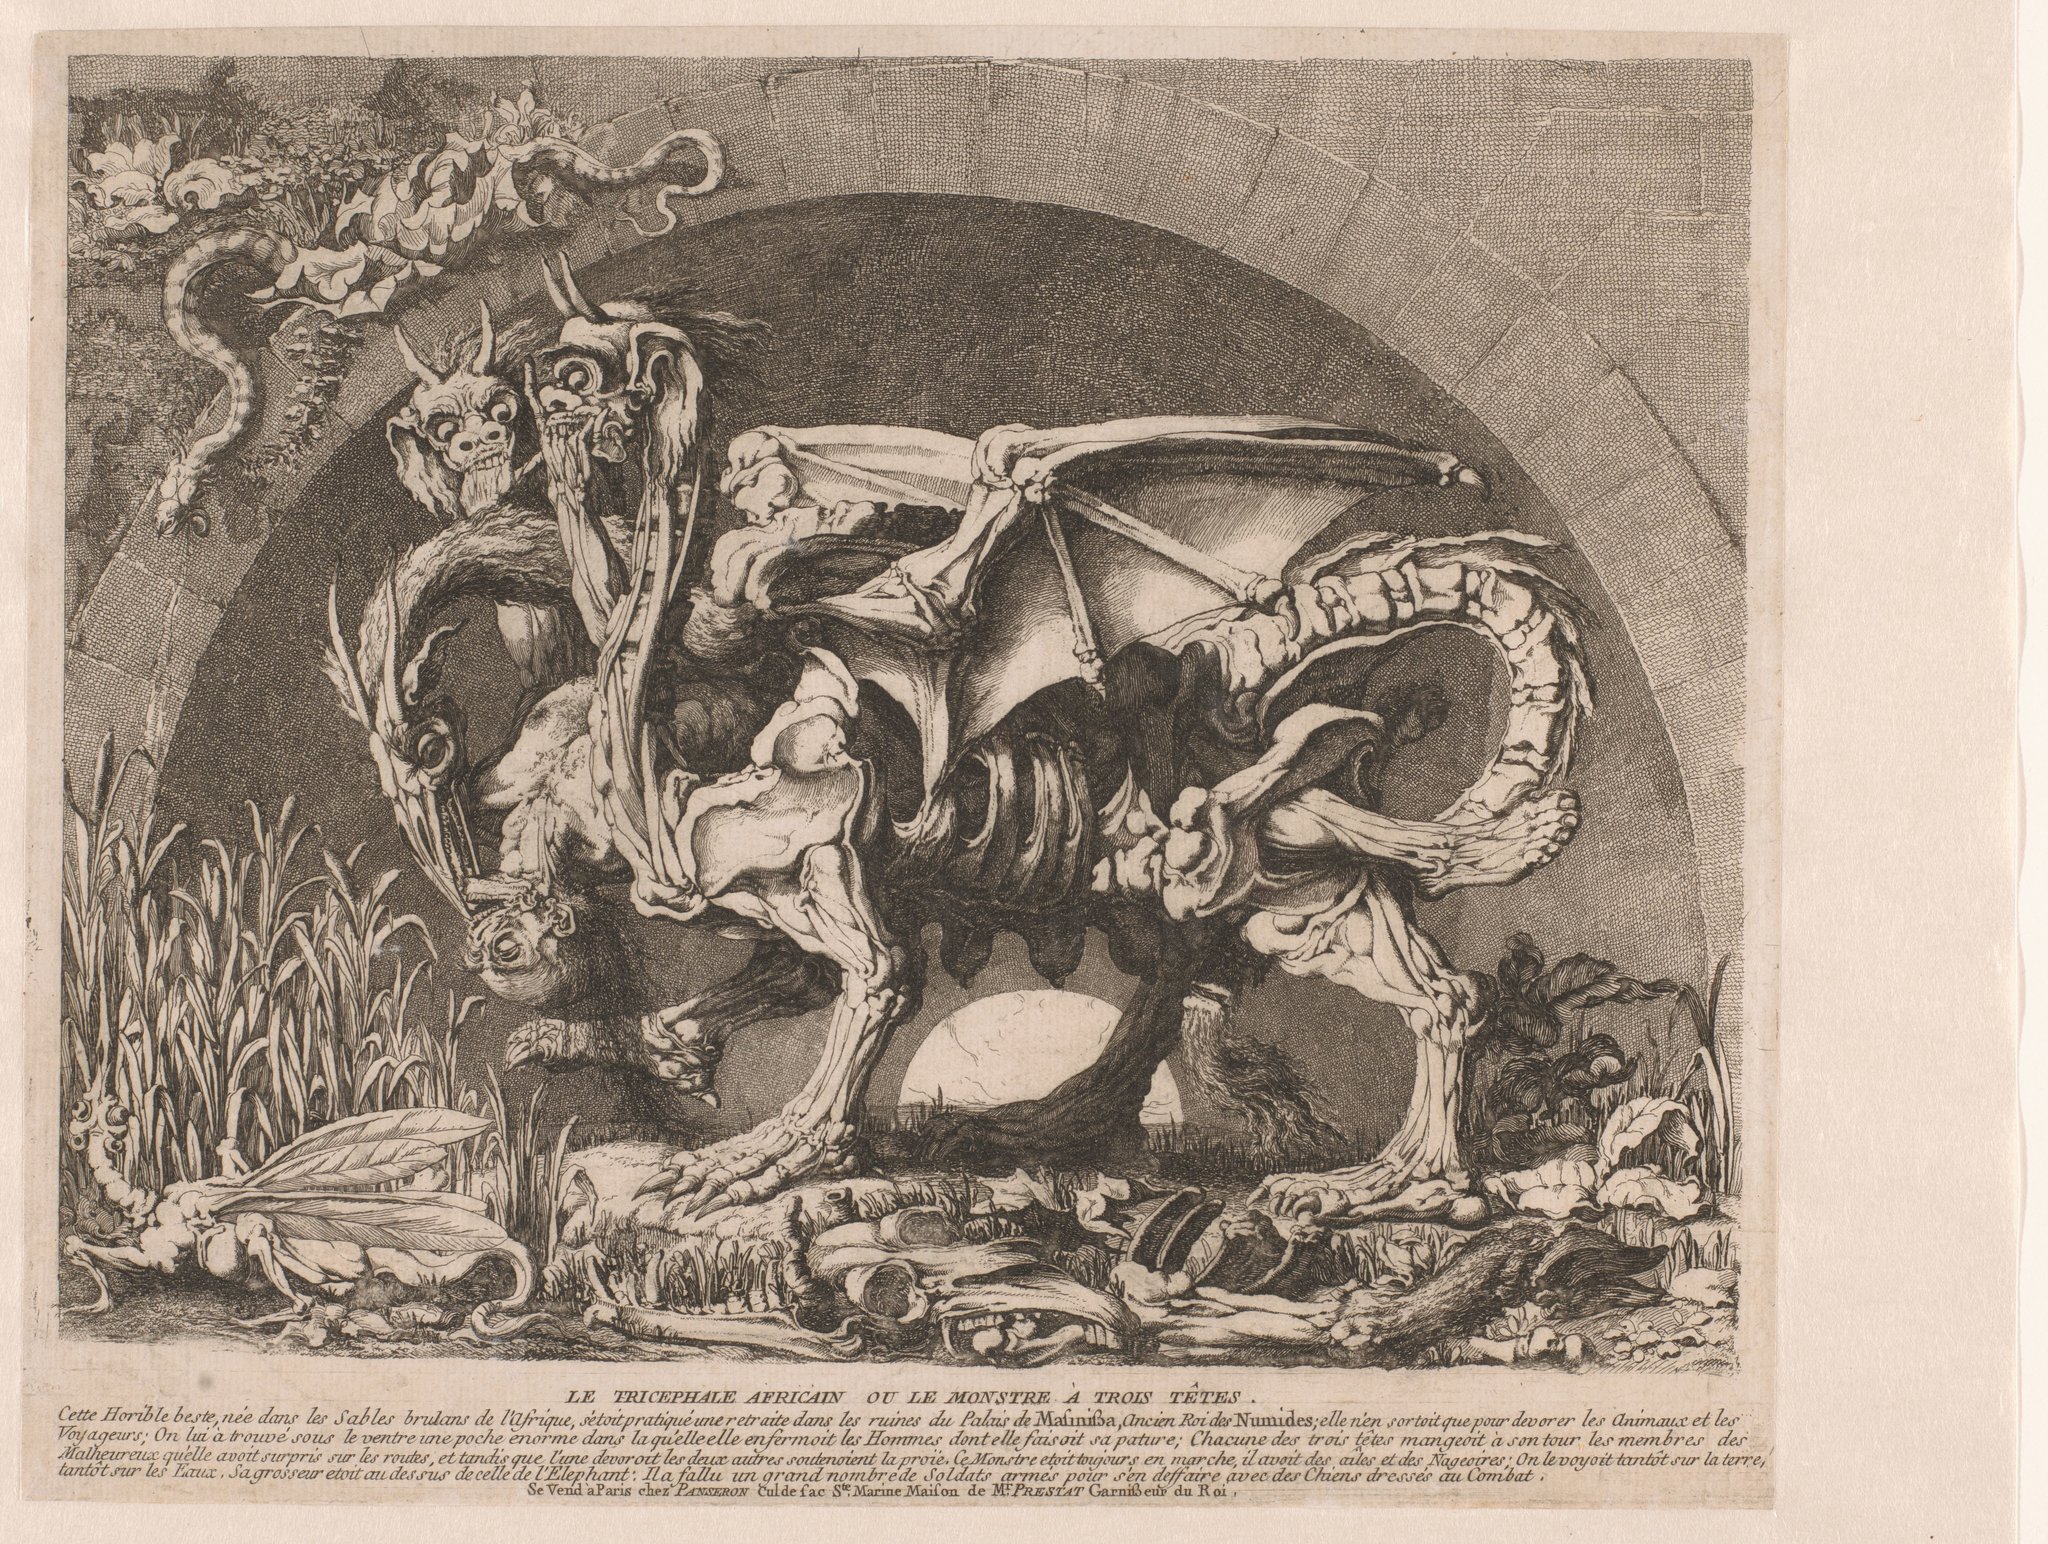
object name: print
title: Chimera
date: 1777-1784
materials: paper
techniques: etching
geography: italy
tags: chimera (lion/goat/snake); 'chimera' (ripa)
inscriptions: collector's mark: Lugt 2760, collector's mark: Lugt 2228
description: The architect and set designer Desprez favoured theatrical depictions. Here he offers a free interpretation of a chimera, a hybrid mythological creature, which he turns into a three-headed desert monster hunting for food in front of a run-down palace in North Africa. The partly digested carcass of its last victim still sticks out of its ribcage and the ground is littered with animal remains.